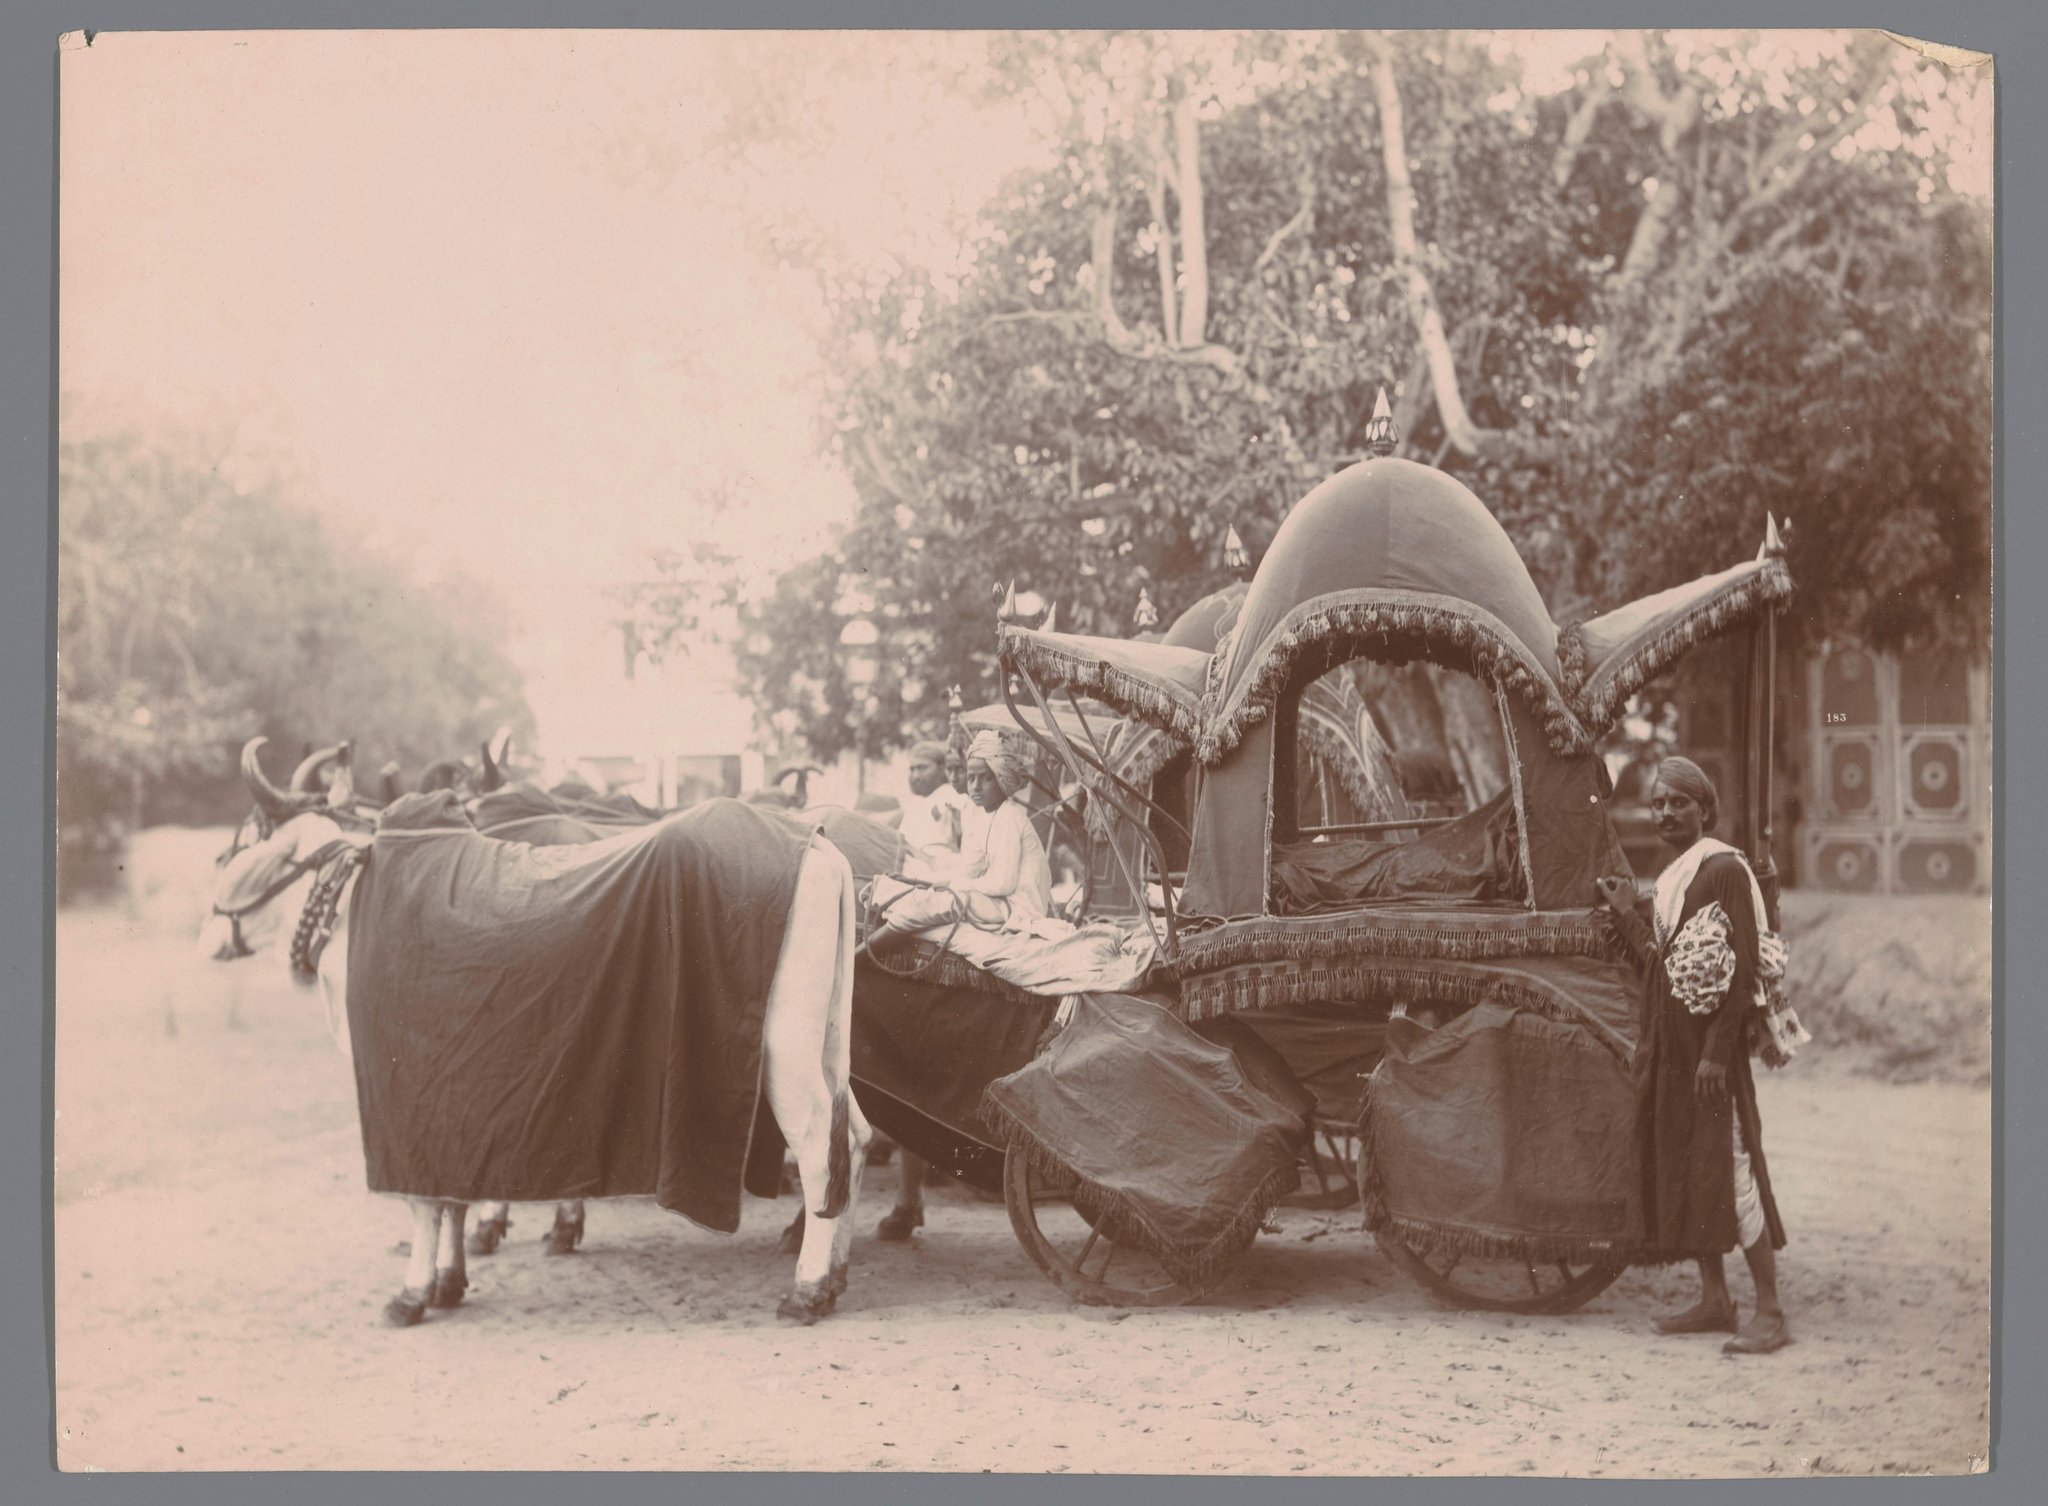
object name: photograph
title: Covered passenger carriages pulled by two oxen, India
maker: Anonymous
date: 1880-1920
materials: paper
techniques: gelatin silver print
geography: british india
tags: four-wheeled vehicle drawn by two animals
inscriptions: number: ‘183’